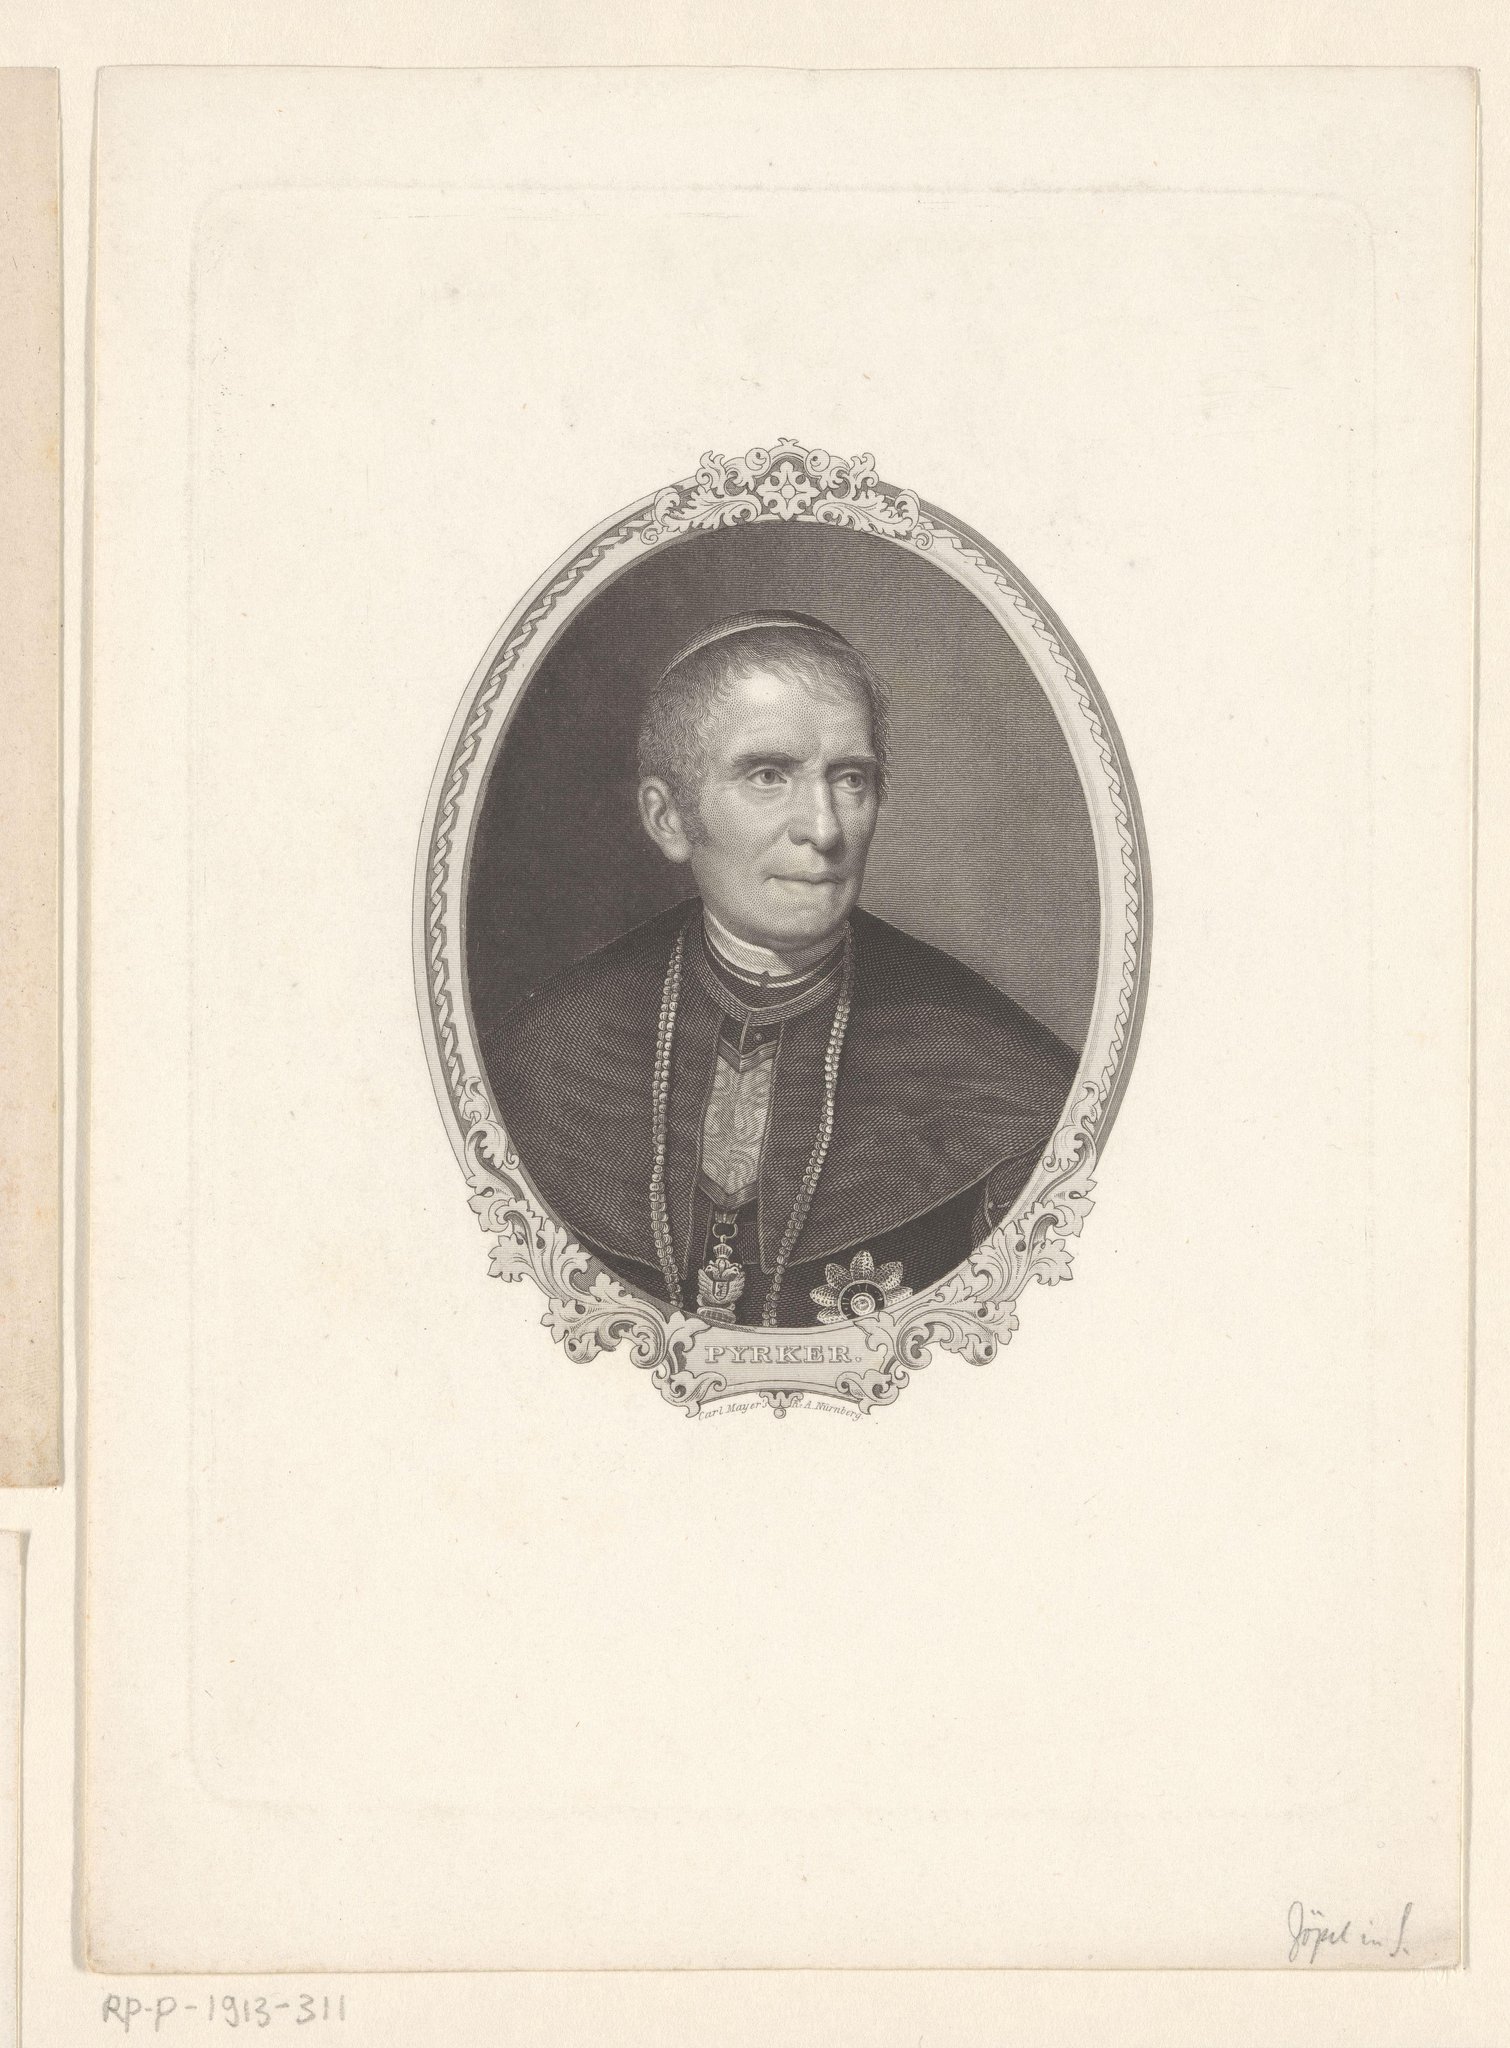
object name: print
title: Portret van Johann Ladislaus Pyrker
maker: carl mayer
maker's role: print maker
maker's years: 1798-1868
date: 1808-1868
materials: paper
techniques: engraving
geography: nuremberg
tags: vienna, theologian, historical persons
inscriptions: collector's mark: Lugt 2228